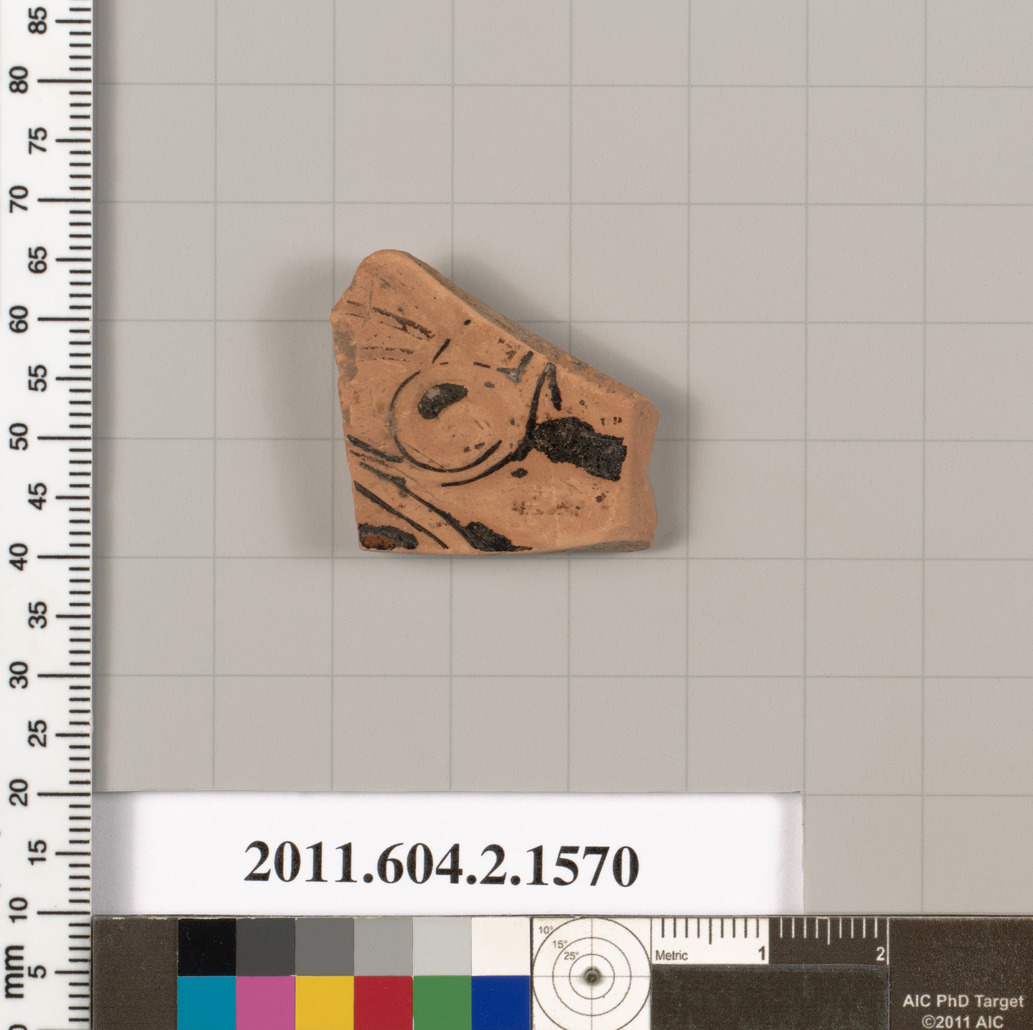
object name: skyphos fragment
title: Terracotta fragment of a skyphos (deep drinking cup)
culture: greek, attic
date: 450-426 BCE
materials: terracotta